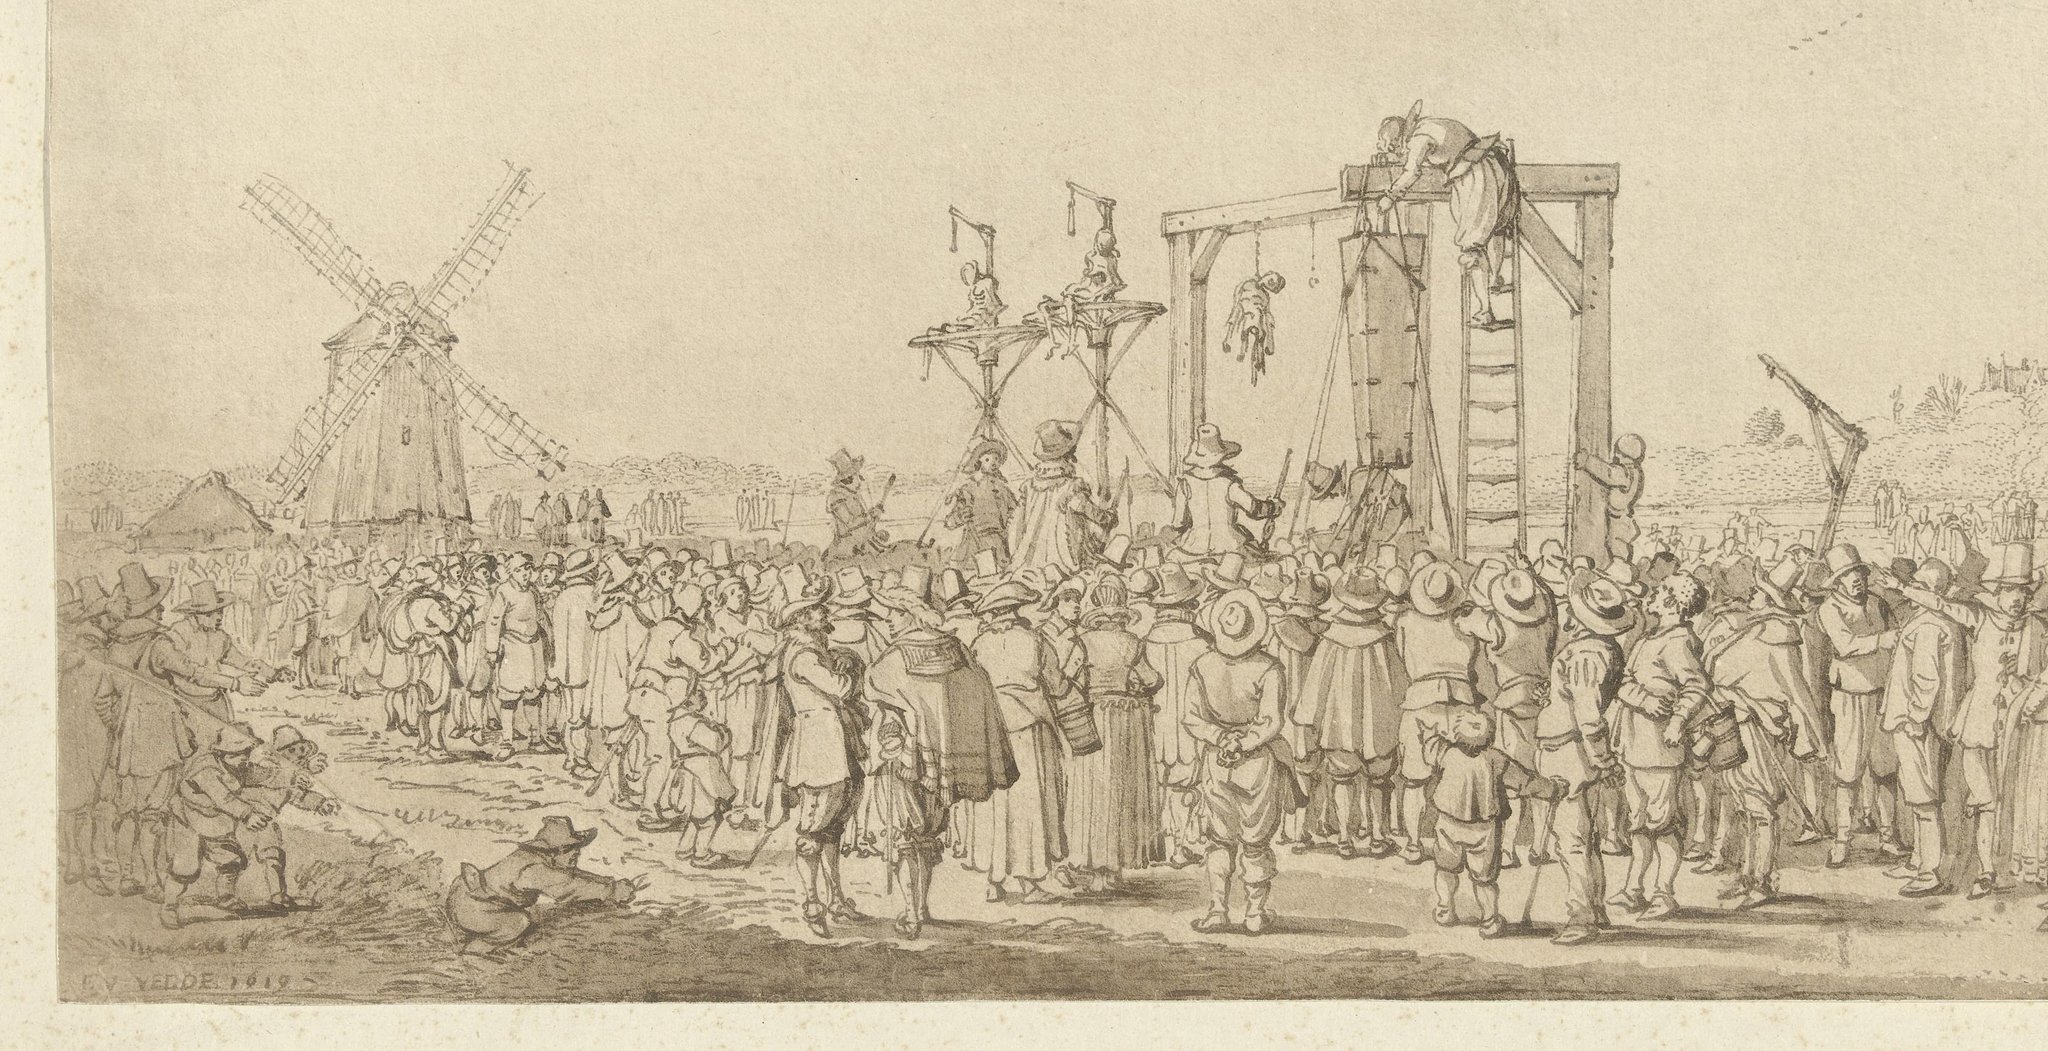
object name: print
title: De doodskist van Ledenberg wordt aan de galg gehangen, 1619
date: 1895-1900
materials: paper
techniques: printing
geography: netherlands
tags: utrecht, violent death by hanging, seeking death, suicide, the hague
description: De kist met de overblijfselen van Gilles van Ledenberg wordt aan de galg gehangen buiten Den Haag, 15 mei 1619. Van Ledenberg had in de nacht van 28 op 29 september 1618 zelfmoord gepleegd en is in mei 1619 nog eens ter dood veroordeeld. Reproductie van een tekening.